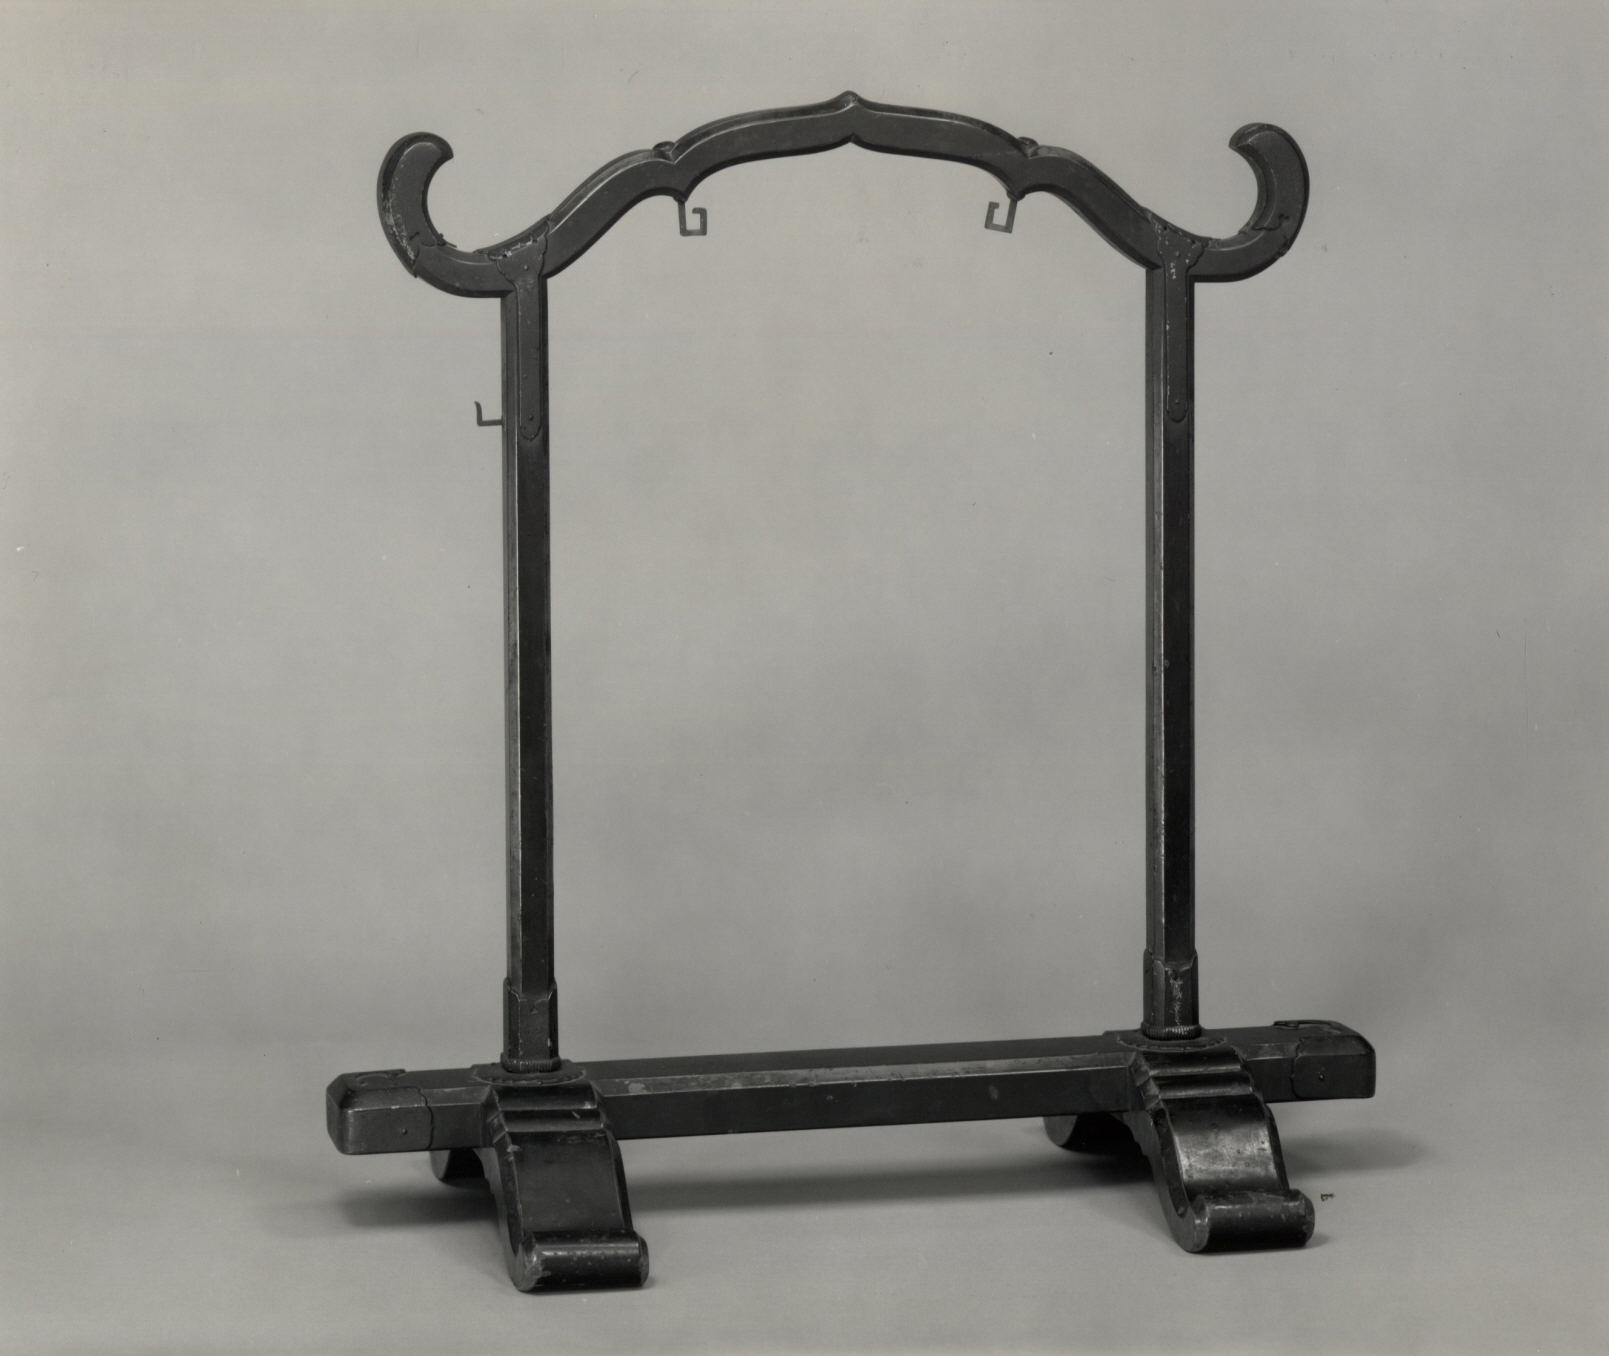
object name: gong stand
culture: japanese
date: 1392-1573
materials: gilt bronze, lacquer, wood, iron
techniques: chasing